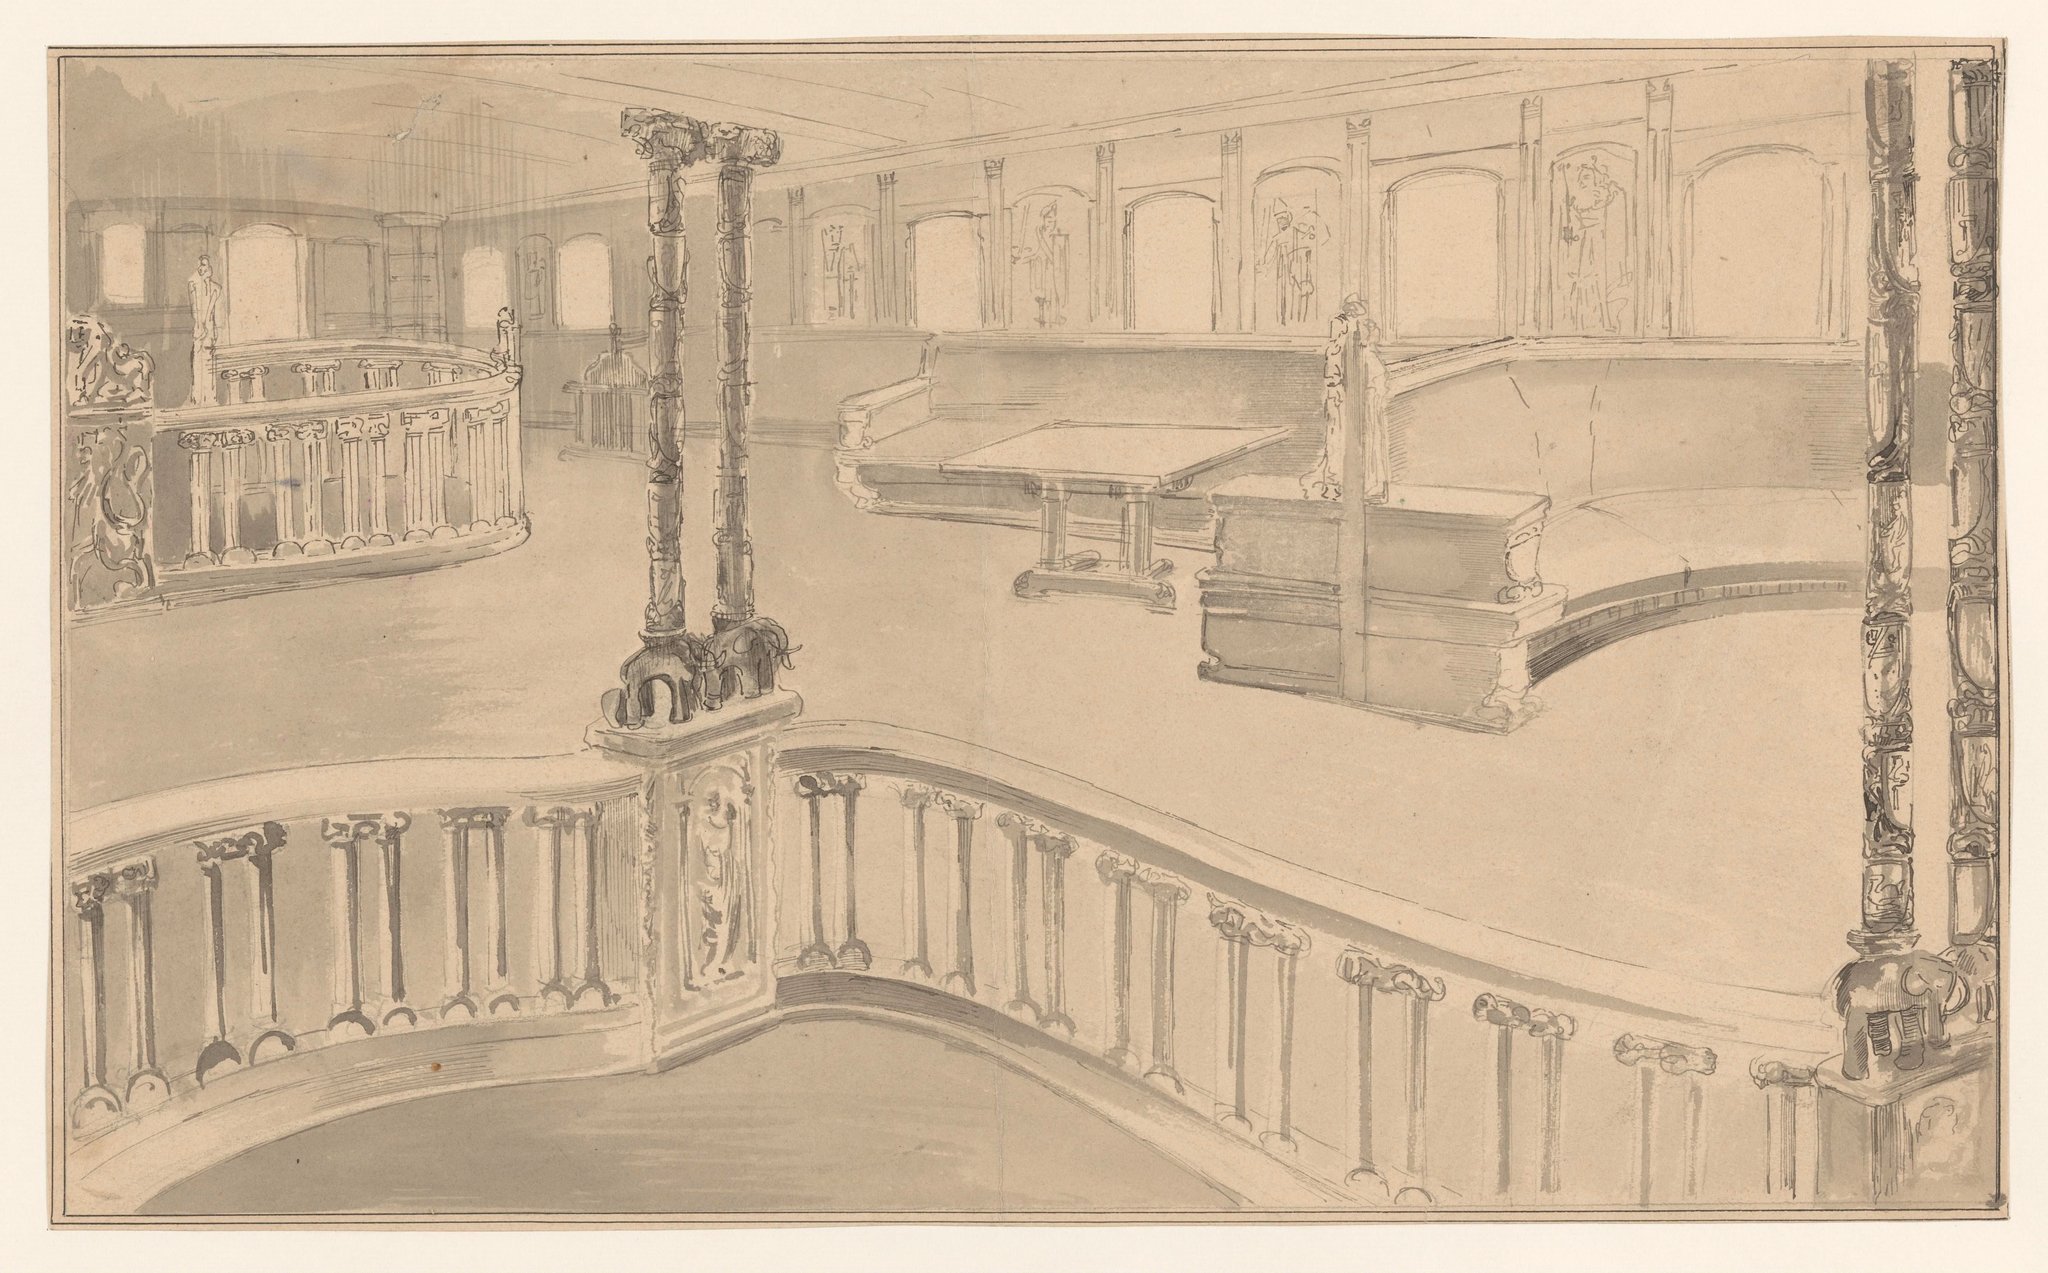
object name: drawing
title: Ontwerp voor het interieur van een deksalon met open balustrade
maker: carel adolph lion cachet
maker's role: draughtsman, print maker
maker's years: 1864-1945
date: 1874-1945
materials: ink, paper, pencil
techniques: brush, pen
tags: interior of the house, parts of ship's interior